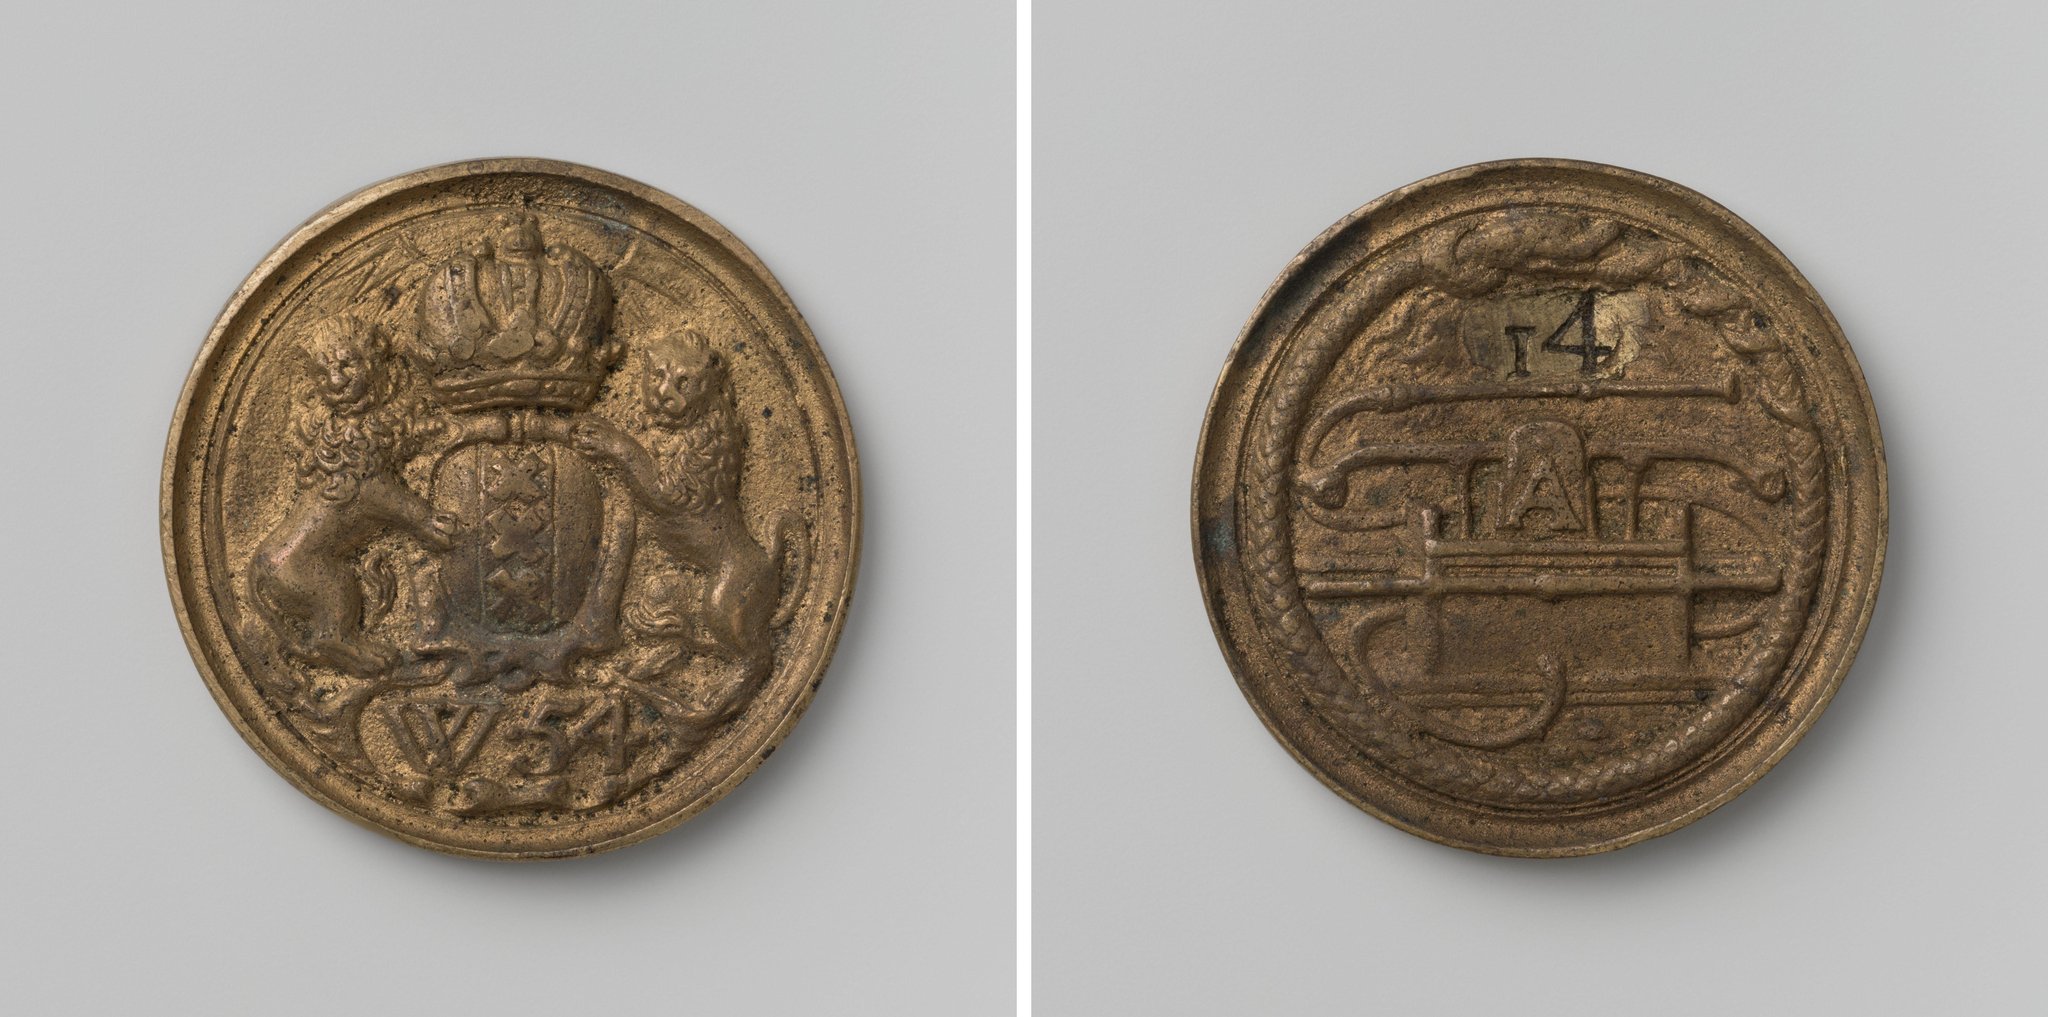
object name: fire engine medal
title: Amsterdam, brandspuitpenning van wijk 54 met no. 14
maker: Anonymous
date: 1680-1800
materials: brass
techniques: casting, engraving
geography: amsterdam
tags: amsterdam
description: Messing penning. Voorzijde: gekroond wapenschild, geflankeerd door twee leeuwen boven cartouche met opschrift W 54. Keerzijde: brandspuit onder cartouche met no. 14 binnen slangerond; op bovenkant van brandspuit: letter A